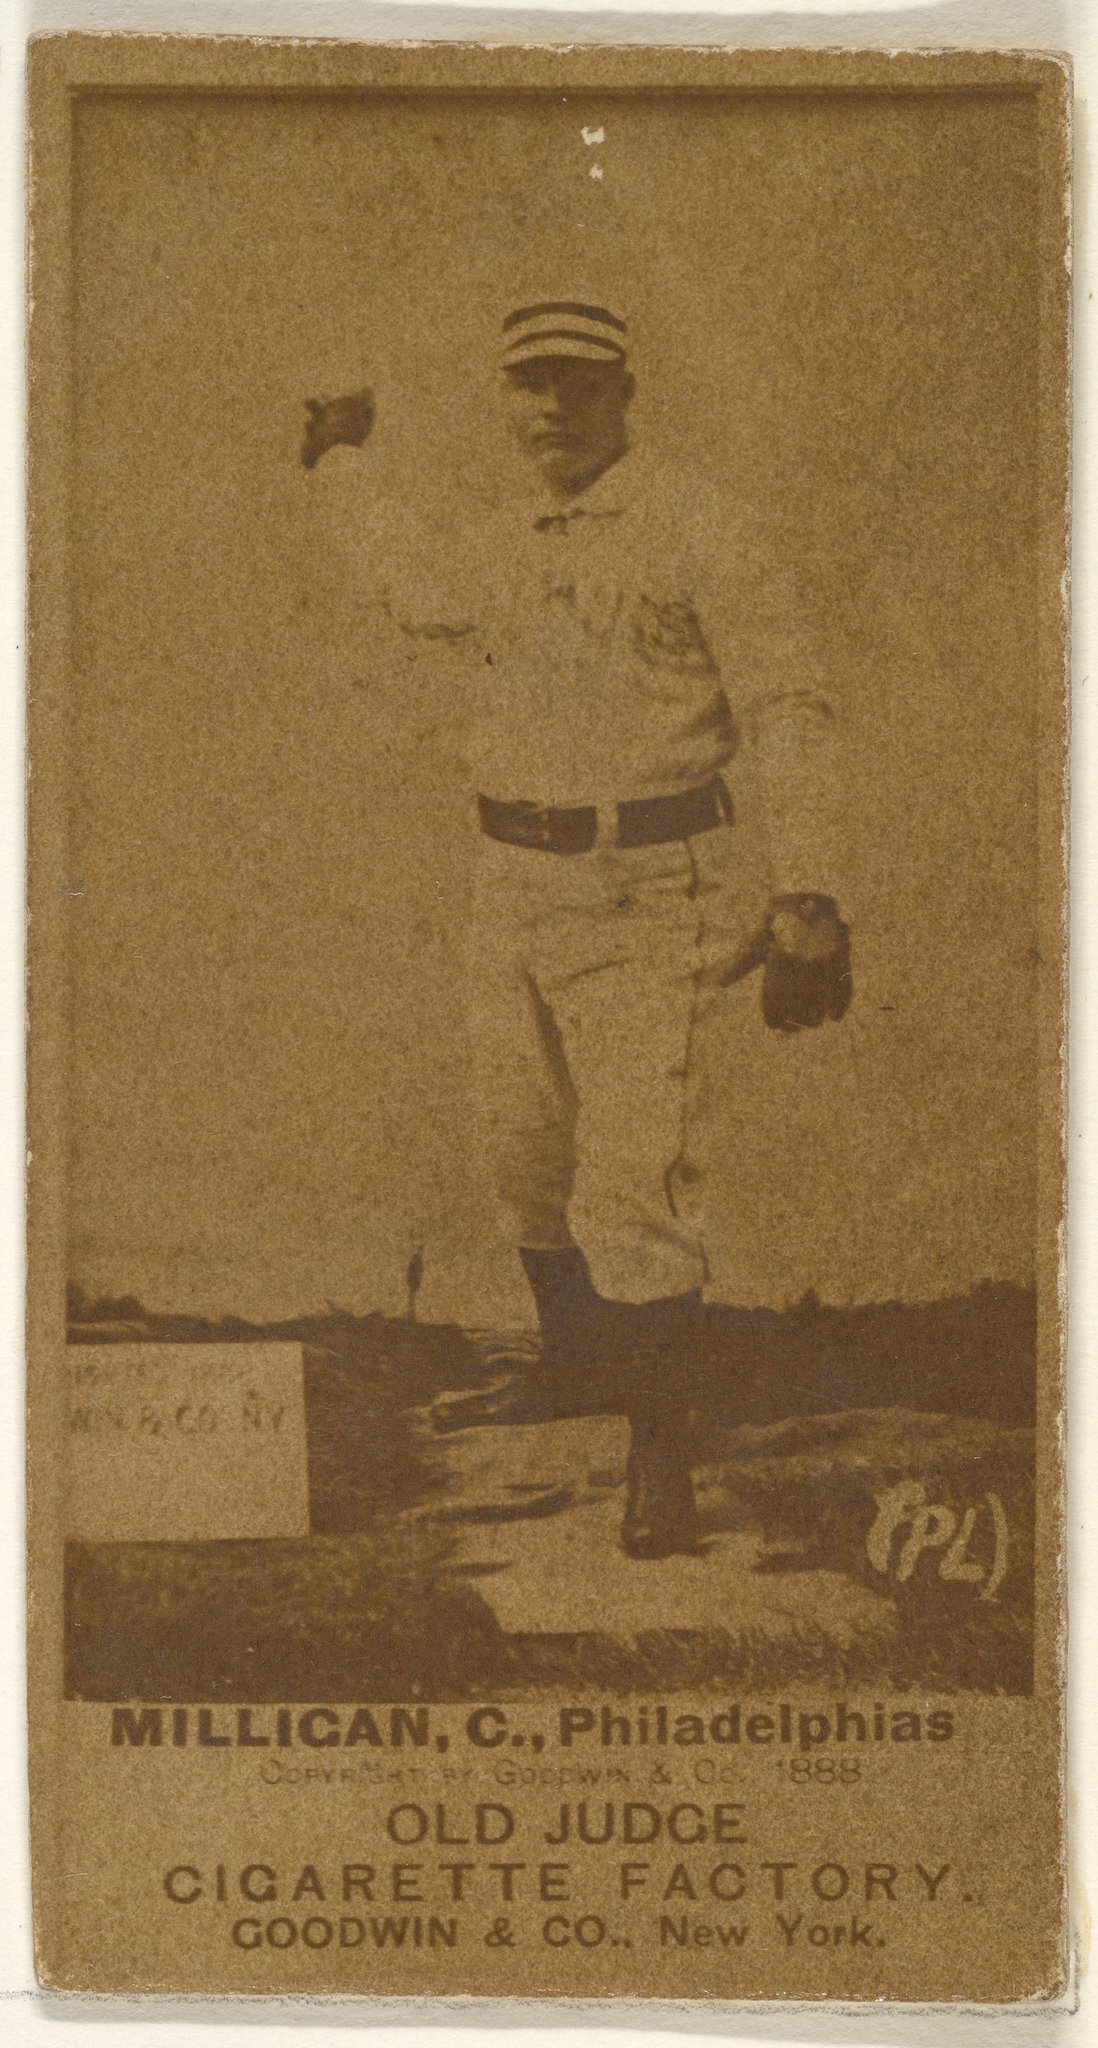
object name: baseball card, photograph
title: John "Jocko" Milligan, Catcher, Philadelphia, from the Old Judge series (N172) for Old Judge Cigarettes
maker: goodwin & company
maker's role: publisher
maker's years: 1850-1950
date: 1888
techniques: albumen silver print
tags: men,portraits,baseball,athletes